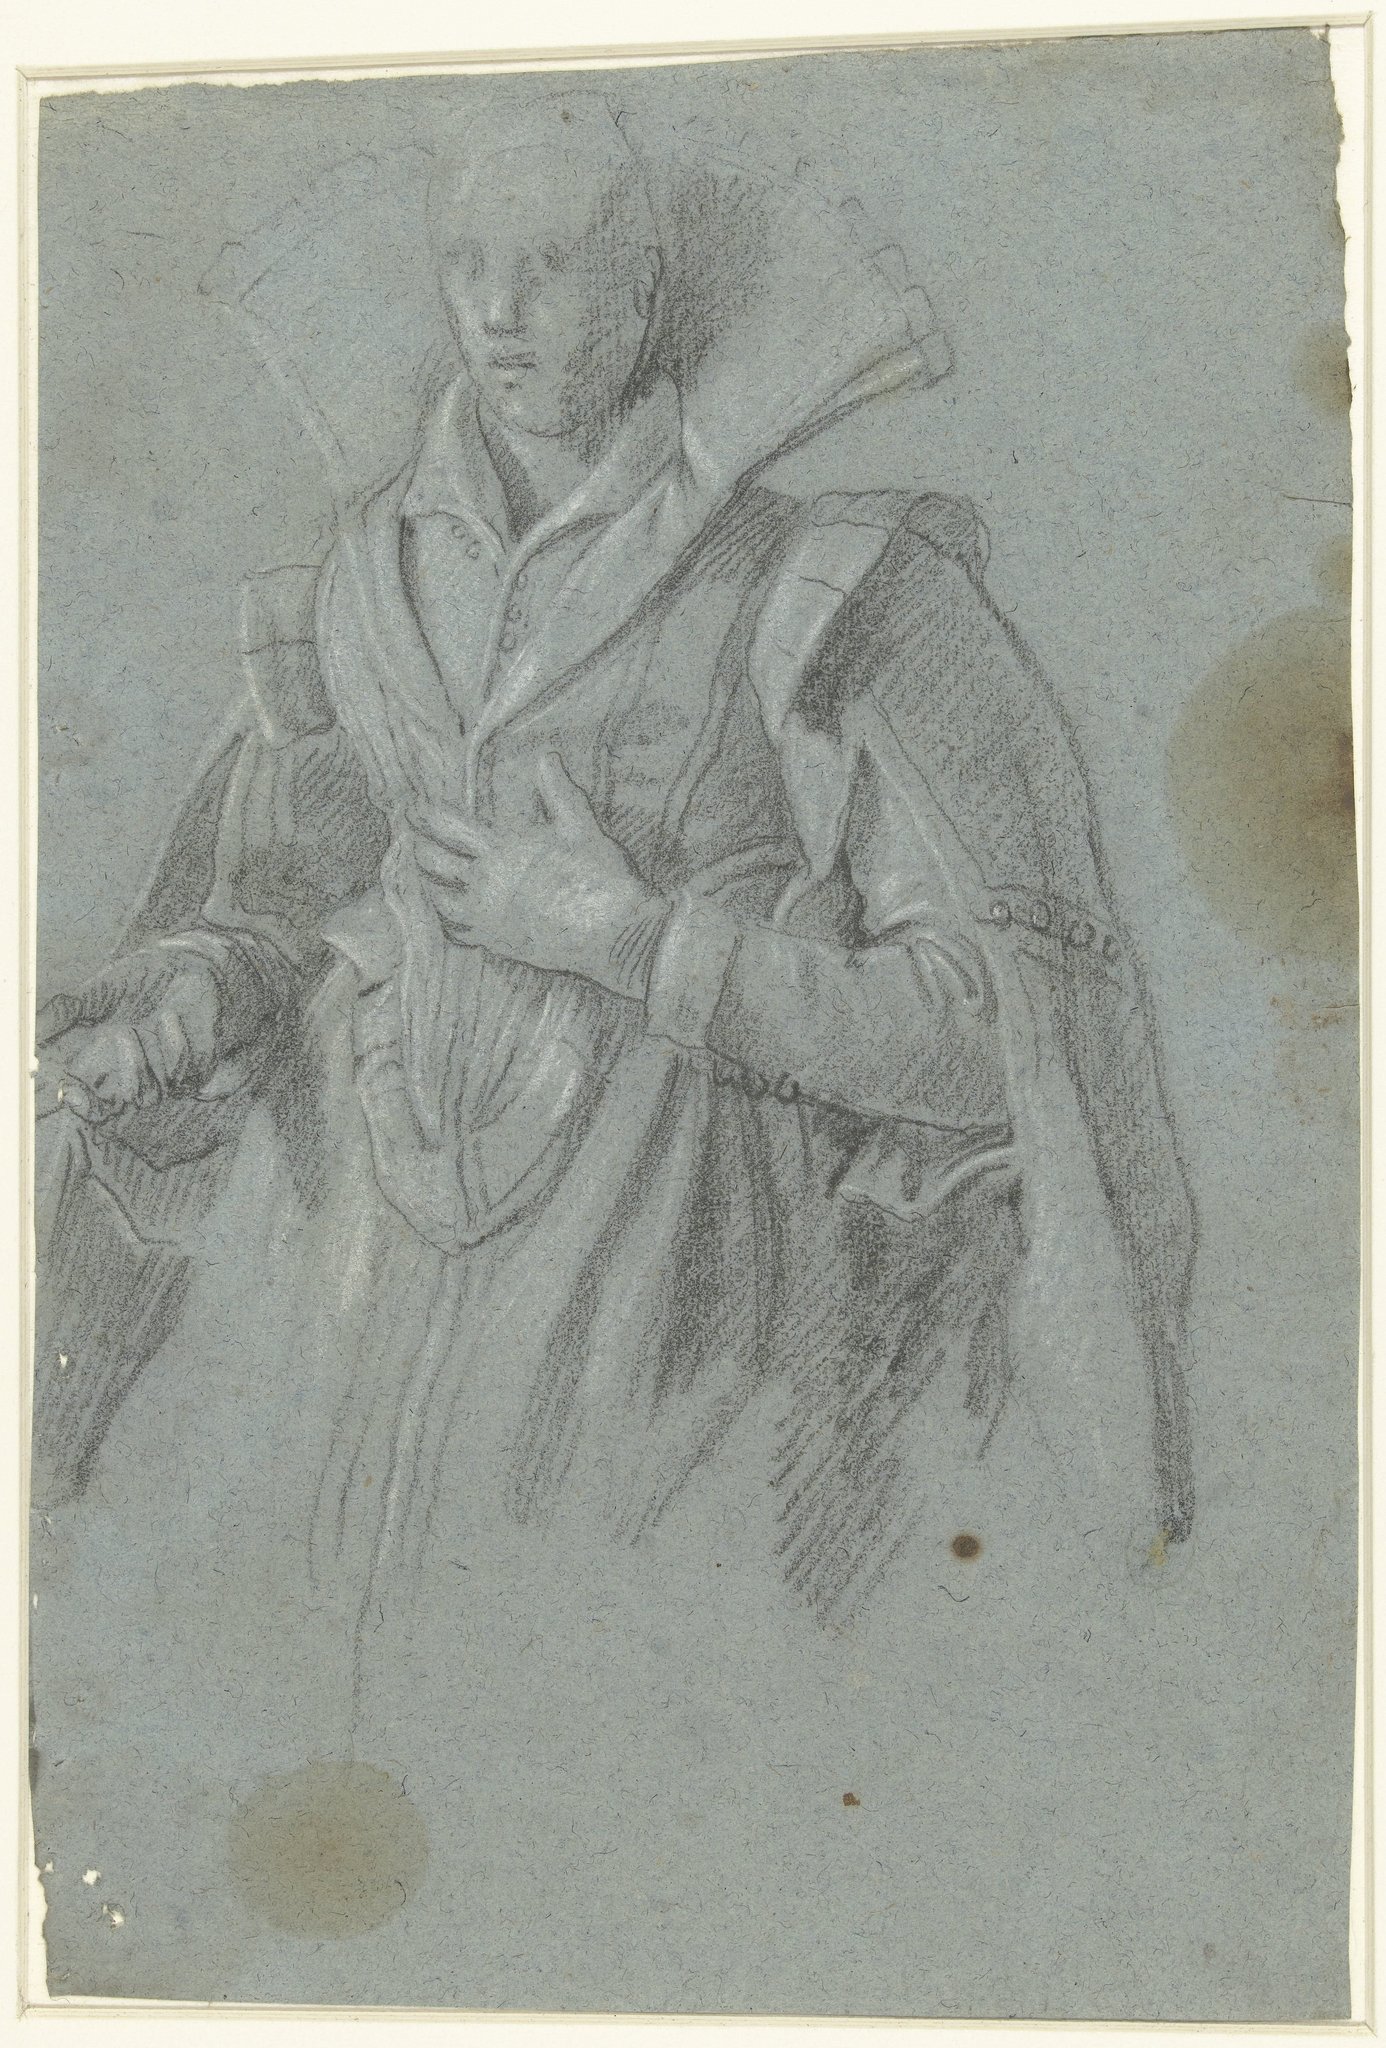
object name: drawing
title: Schetsbladen met figuurstudies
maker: Anonymous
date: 1610-1630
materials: chalk, paper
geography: verona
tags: standing figure - aa - female human figure